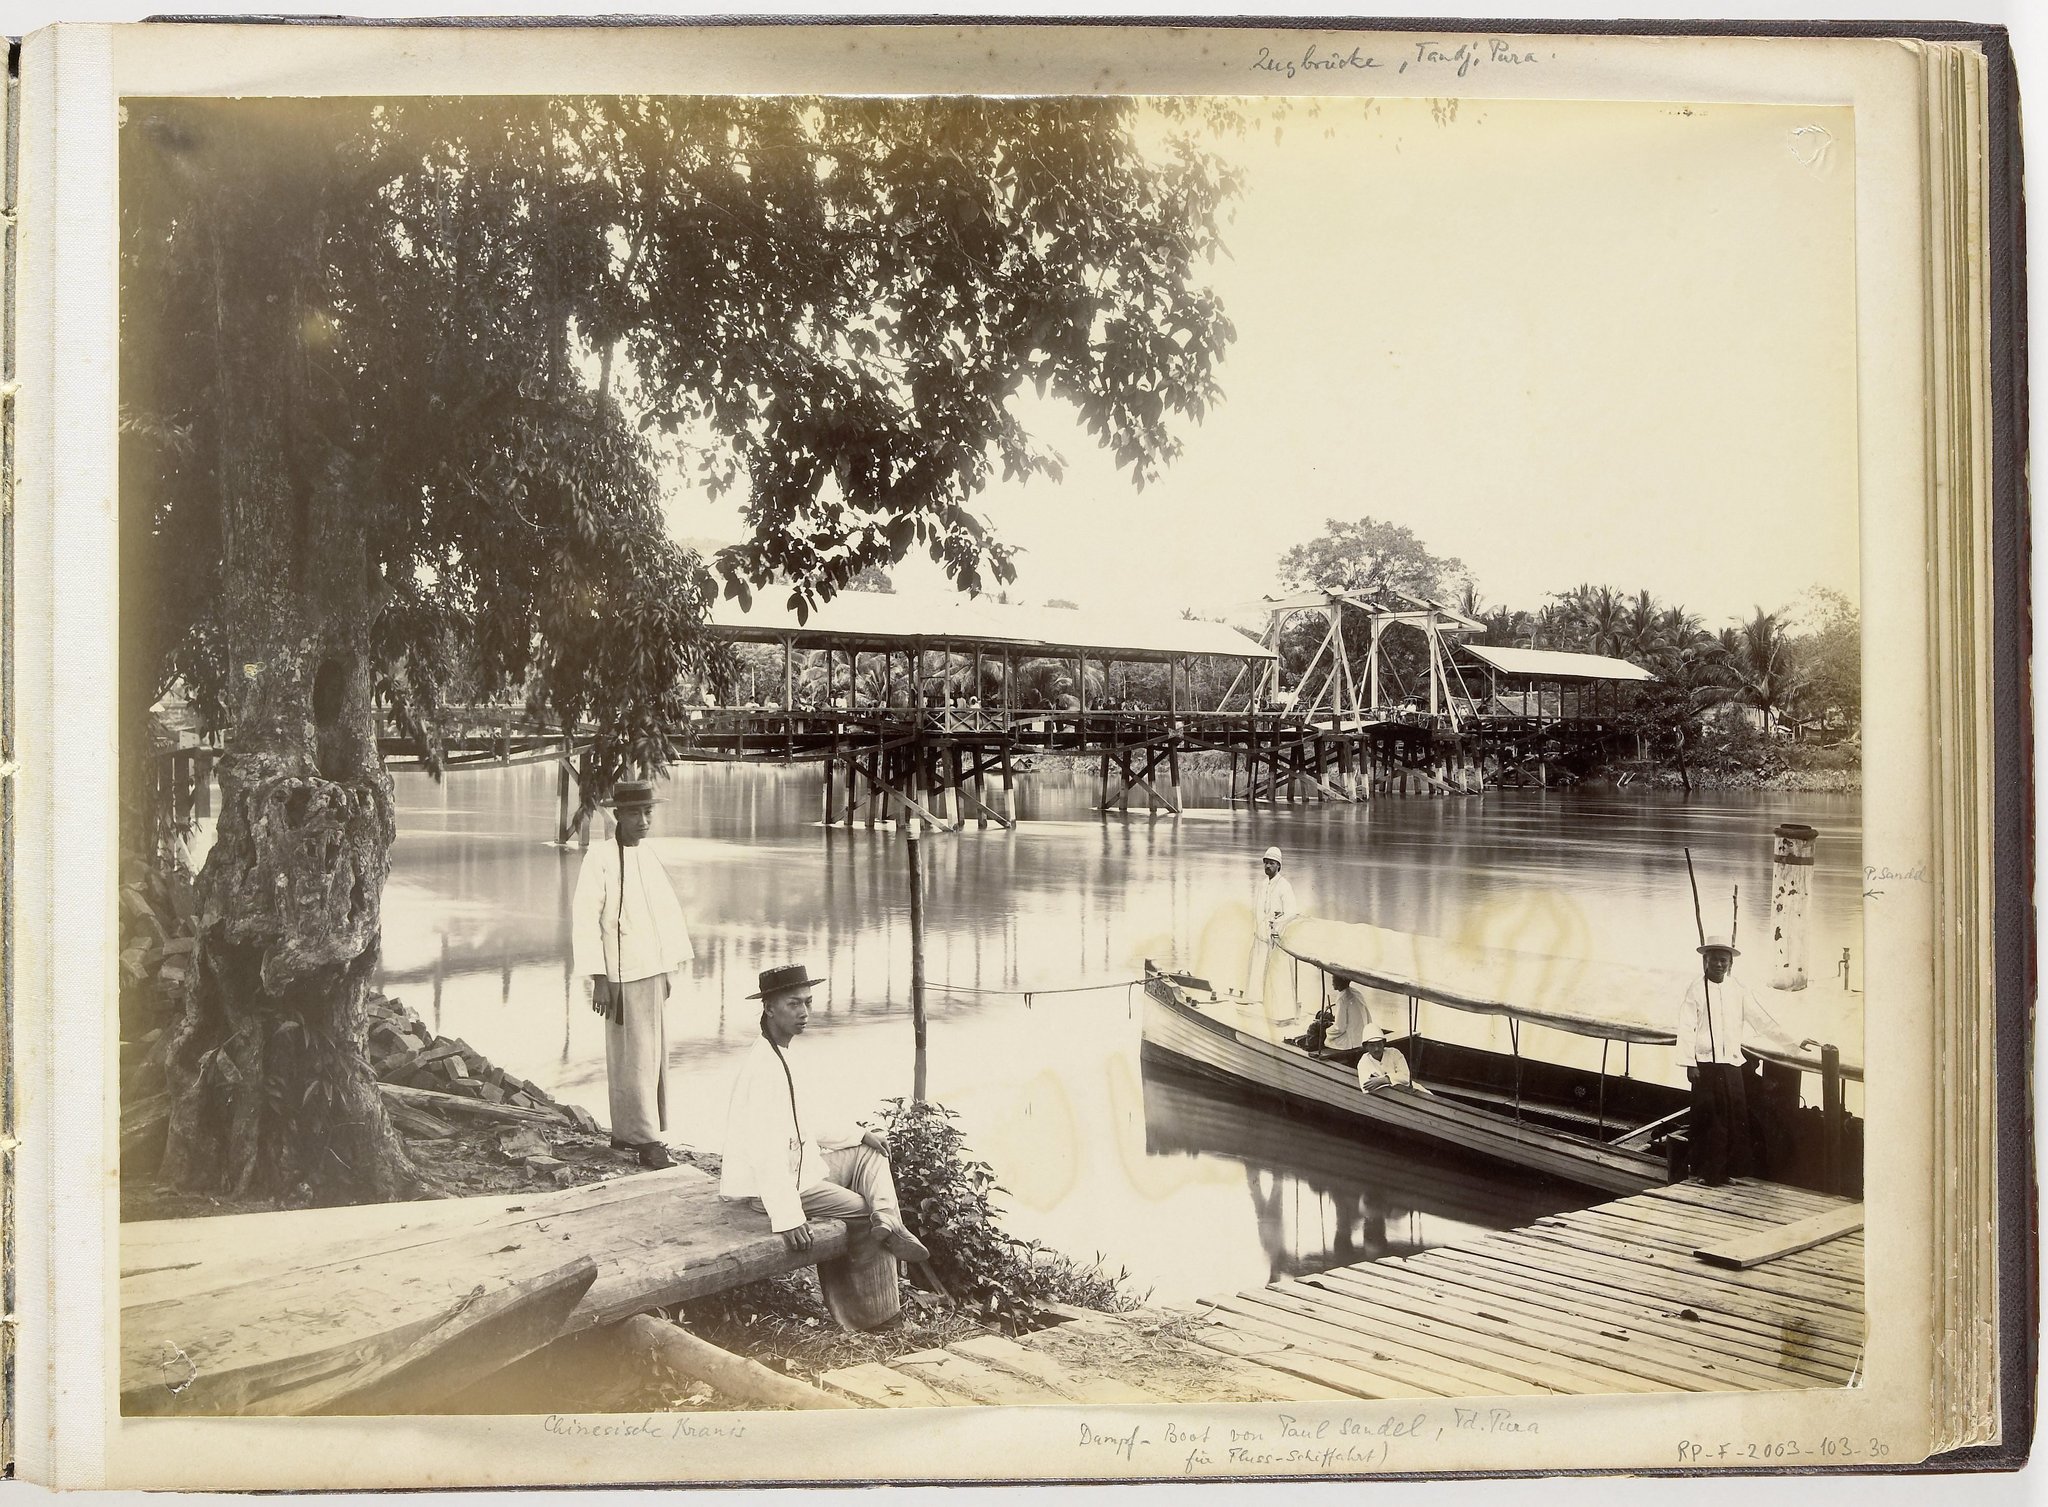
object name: photograph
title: Paul Sandel in zijn stoomboot met op de achtergrond de Sandelbrug en op de voorgrond twee Chinese bedienden, Tandjong Poera, Langkat Sumatra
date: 1890-1900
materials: cardboard, paper, photographic support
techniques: albumen print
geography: bindjai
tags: tandjong poera